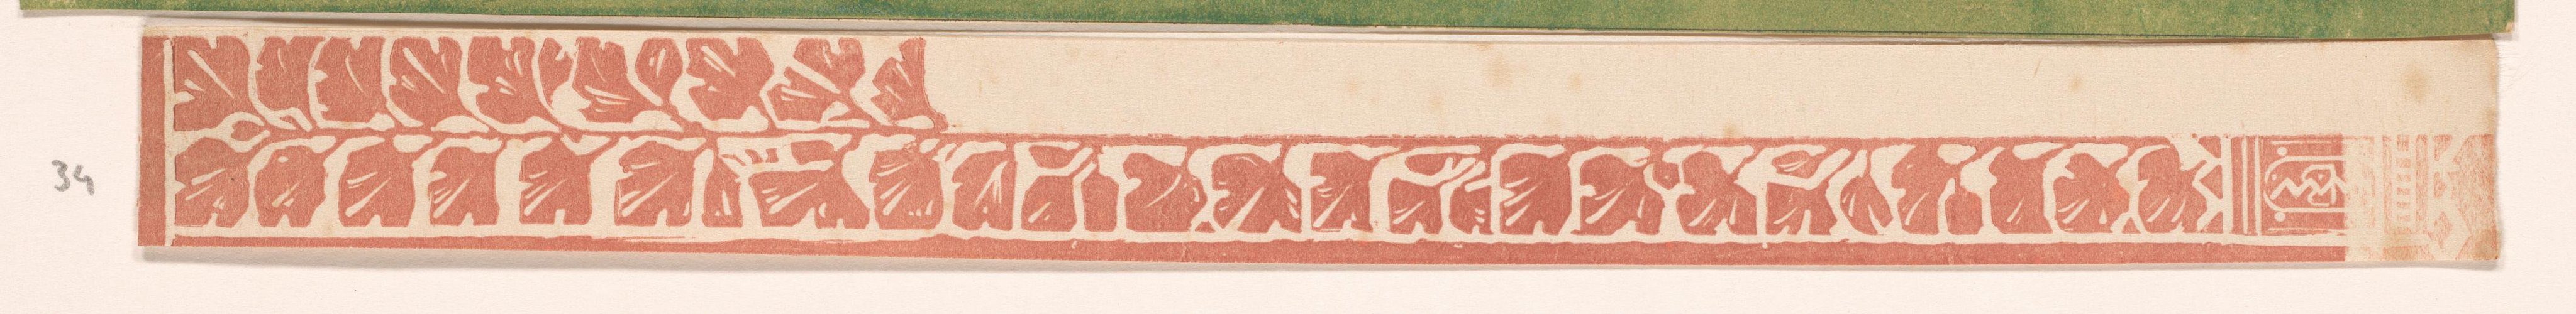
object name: boekillustratie ontwerp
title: Ornament met bladeren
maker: bernard willem wierink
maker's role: draughtsman, print maker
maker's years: 1856-1939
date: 1910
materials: paper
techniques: relief print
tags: fable of reynard the fox, foliage, tendrils, branches ~ ornament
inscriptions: collector's mark: Lugt 2228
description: Ontwerp voor: Streuvels, Stijn (Frank Lateur). Reinaert de Vos naar verschillende uitgaven van het middeleeuwsche epos. Amsterdam: L.J. Veen, 1910. Deze prent is vermoedelijk een plaatsnede, ook al wordt in de literatuur veelal gesproken over een houtsnede. Voor zover Wierink zijn prenten in hoogdruk zelf nader heeft omschreven, heeft hij altijd de term 'plaatsnede' gebruikt.